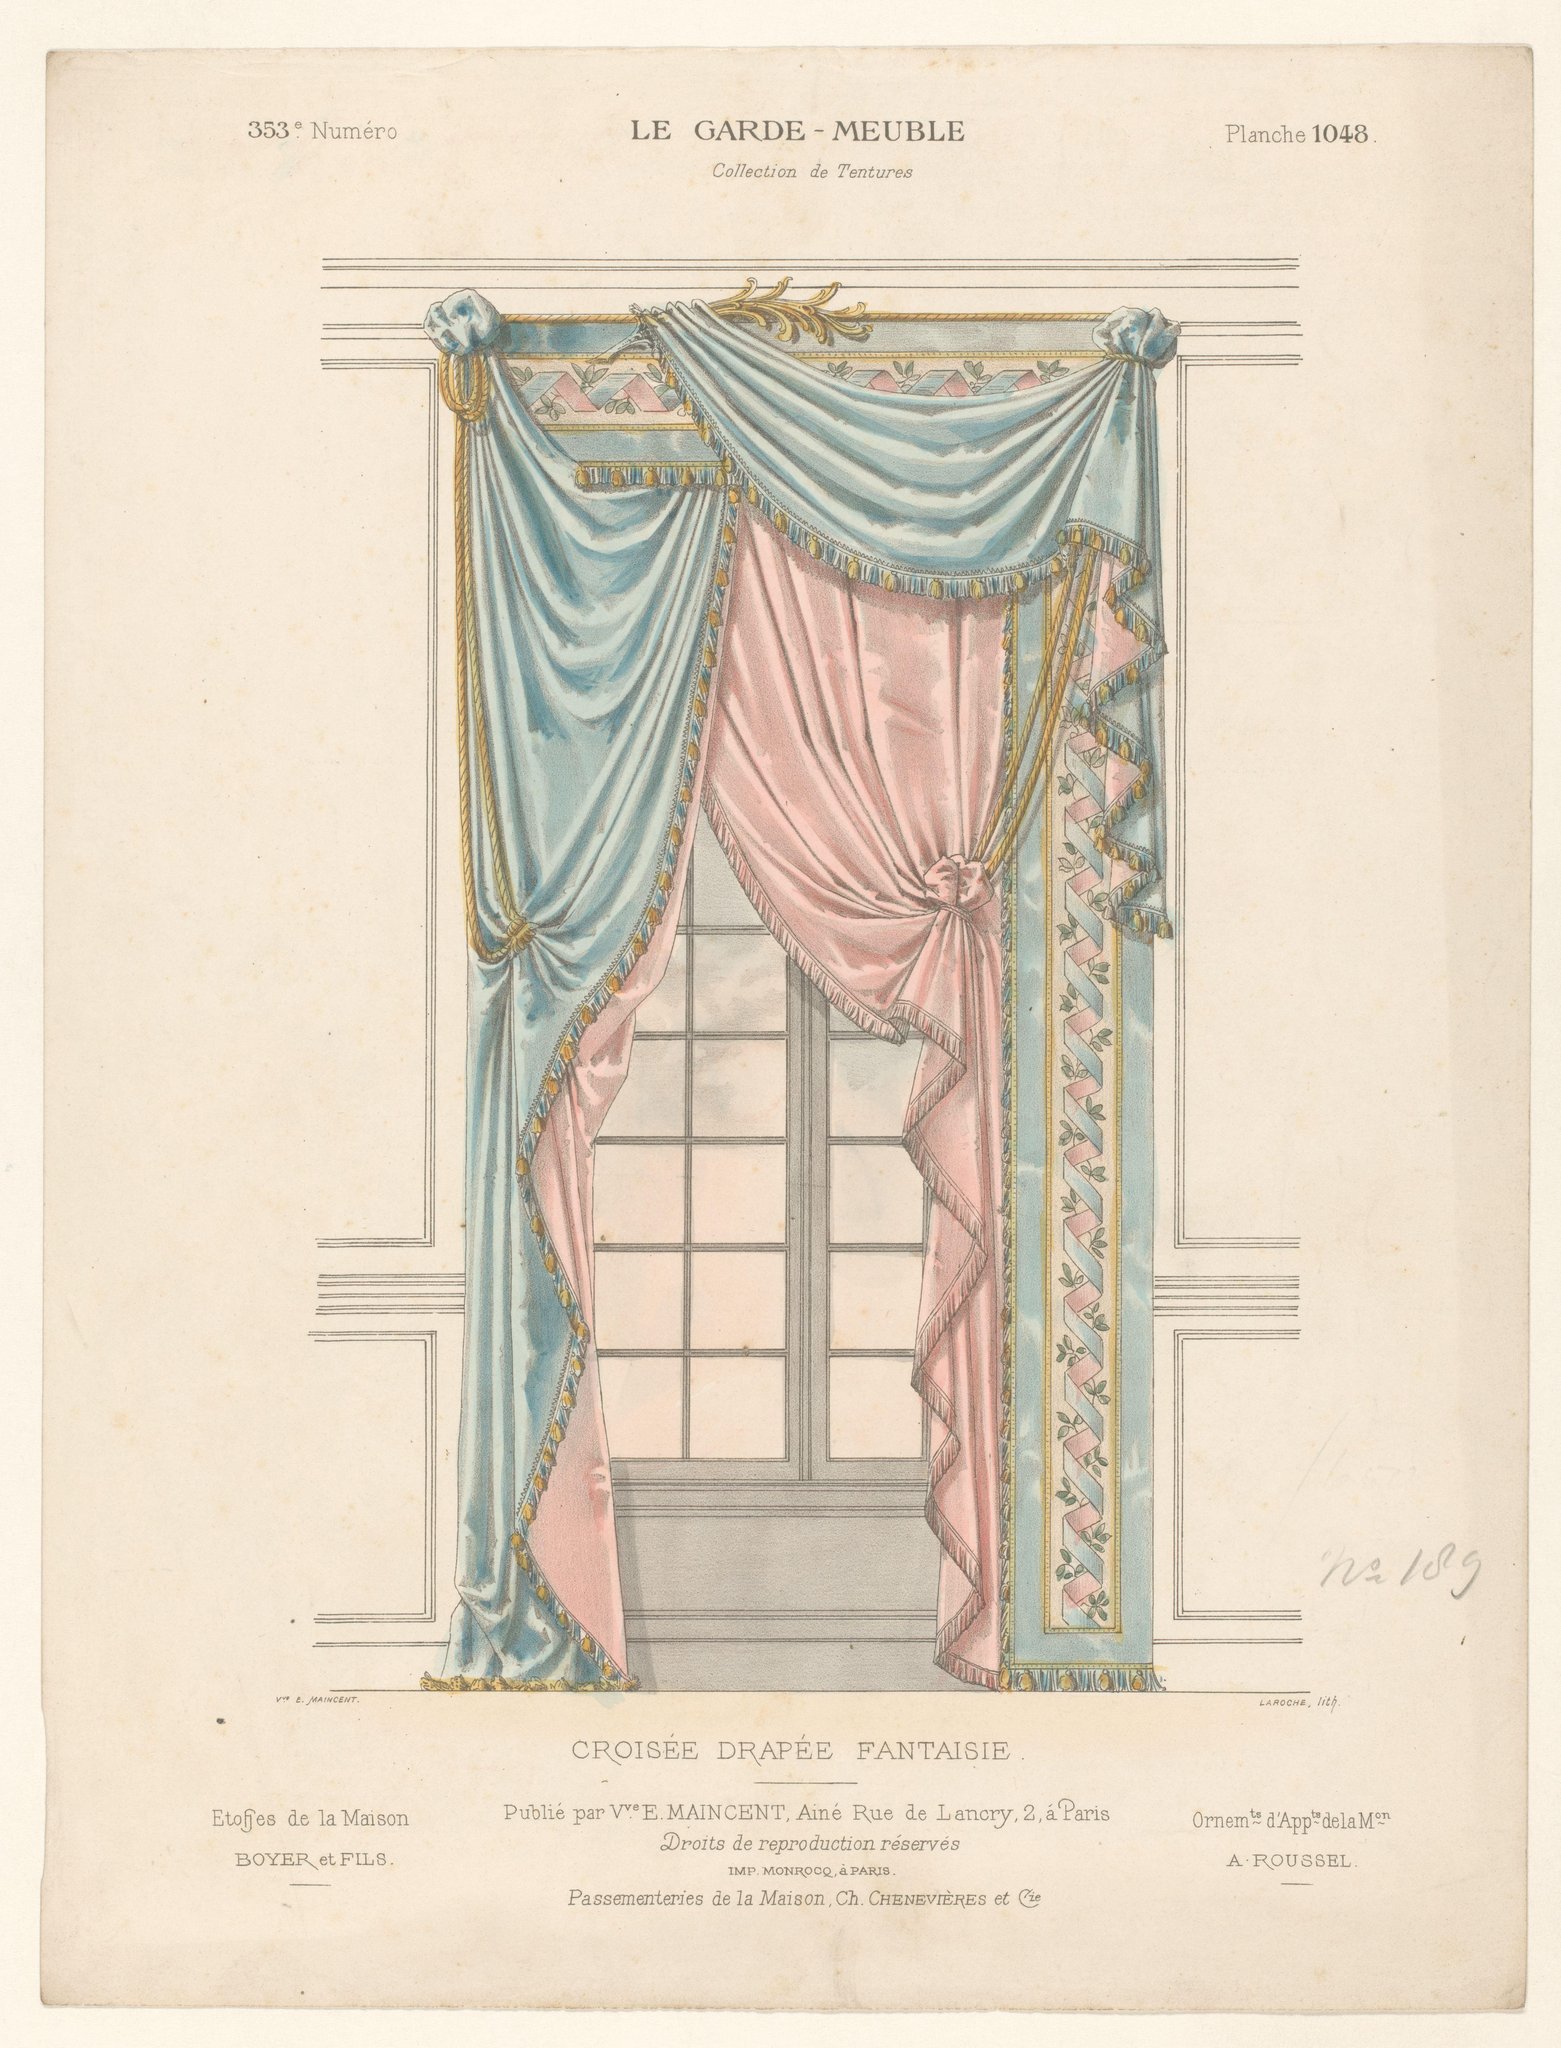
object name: print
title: Croisée drapée Fantaisie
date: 1895-1910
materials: paper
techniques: hand coloring, lithograph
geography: paris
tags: window, hangings and drapery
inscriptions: annotation: ‘no. 189’, : ‘Droits de reproduction réservés.’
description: Kruisvenster met gedrapeerde gordijnen in fantasiestijl. Prent uit 353e Livraison.